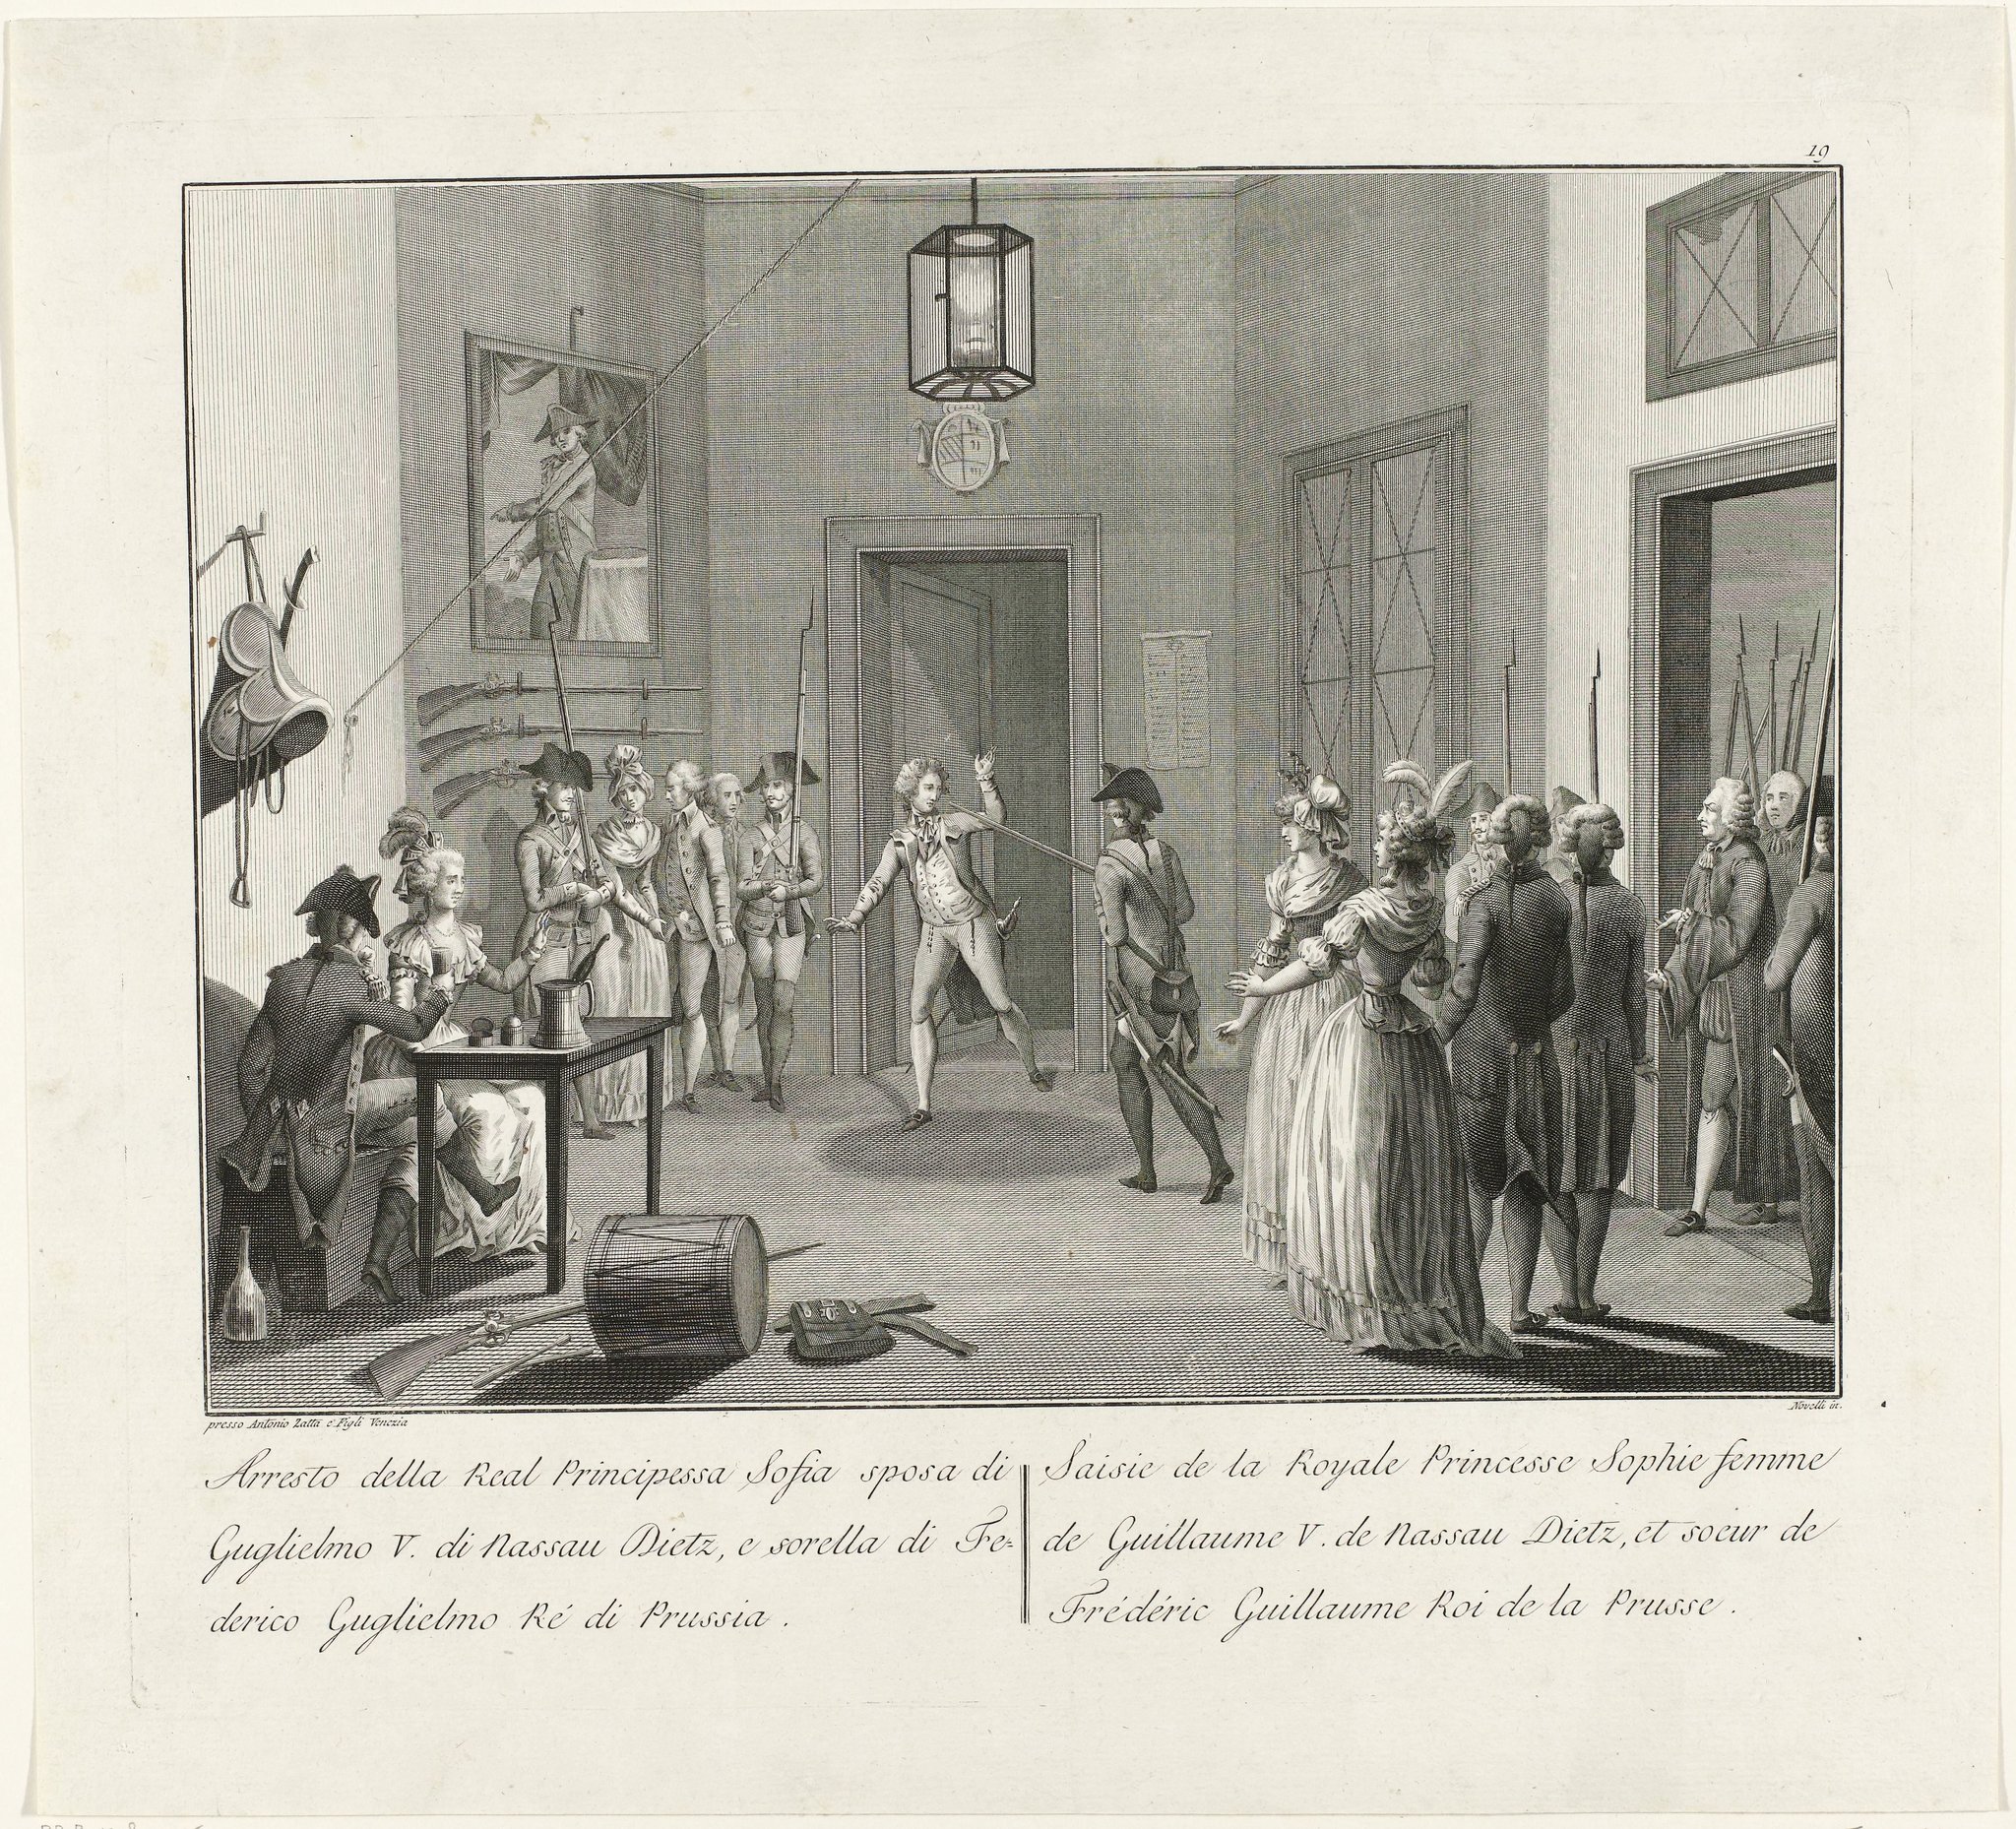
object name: print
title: Arresto della Real Principessa Sofia sposa di Guglielmo V. di Nassu Dietz, e sorella di Federico Guglielmo Ré di Prussia / Saisi de la Royale Princesse Sophie femme de Guillaume V. de Nassau Dietz (...)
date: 1787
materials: paper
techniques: engraving, etching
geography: italy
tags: berlin, painter, draughtsman, wilhelmina of prussia (princess of orange), arrest (of criminal)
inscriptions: collector's mark: Lugt 2228, address: ‘presso Antonio Zatta e Figli Venezia’, signature: ‘Novelli in.’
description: Prinses Wilhelmina van Pruisen aangehouden bij Goejanverwellesluis, 28 juni 1787. In een vertrek met een schilderij, een zadel en geweren aan de muur, zit de prinses, echtgenote van stadhouder Willem V, aan tafel met een bier drinkende soldaat. Rechts twee hofdames, jonkers en soldaten. Met onderschrift in Frans en Italiaans. Rechtsbovenaan gemerkt: 19.